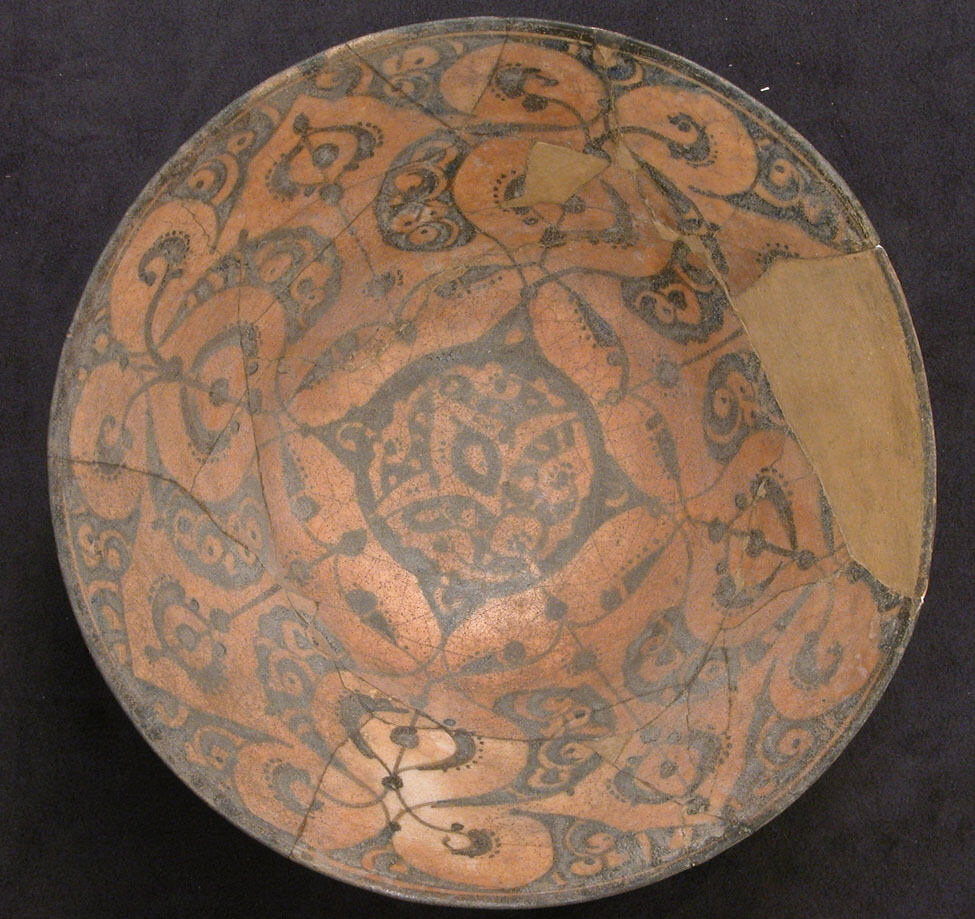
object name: bowl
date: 1201-1300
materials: glaze, stonepaste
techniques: painting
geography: iran